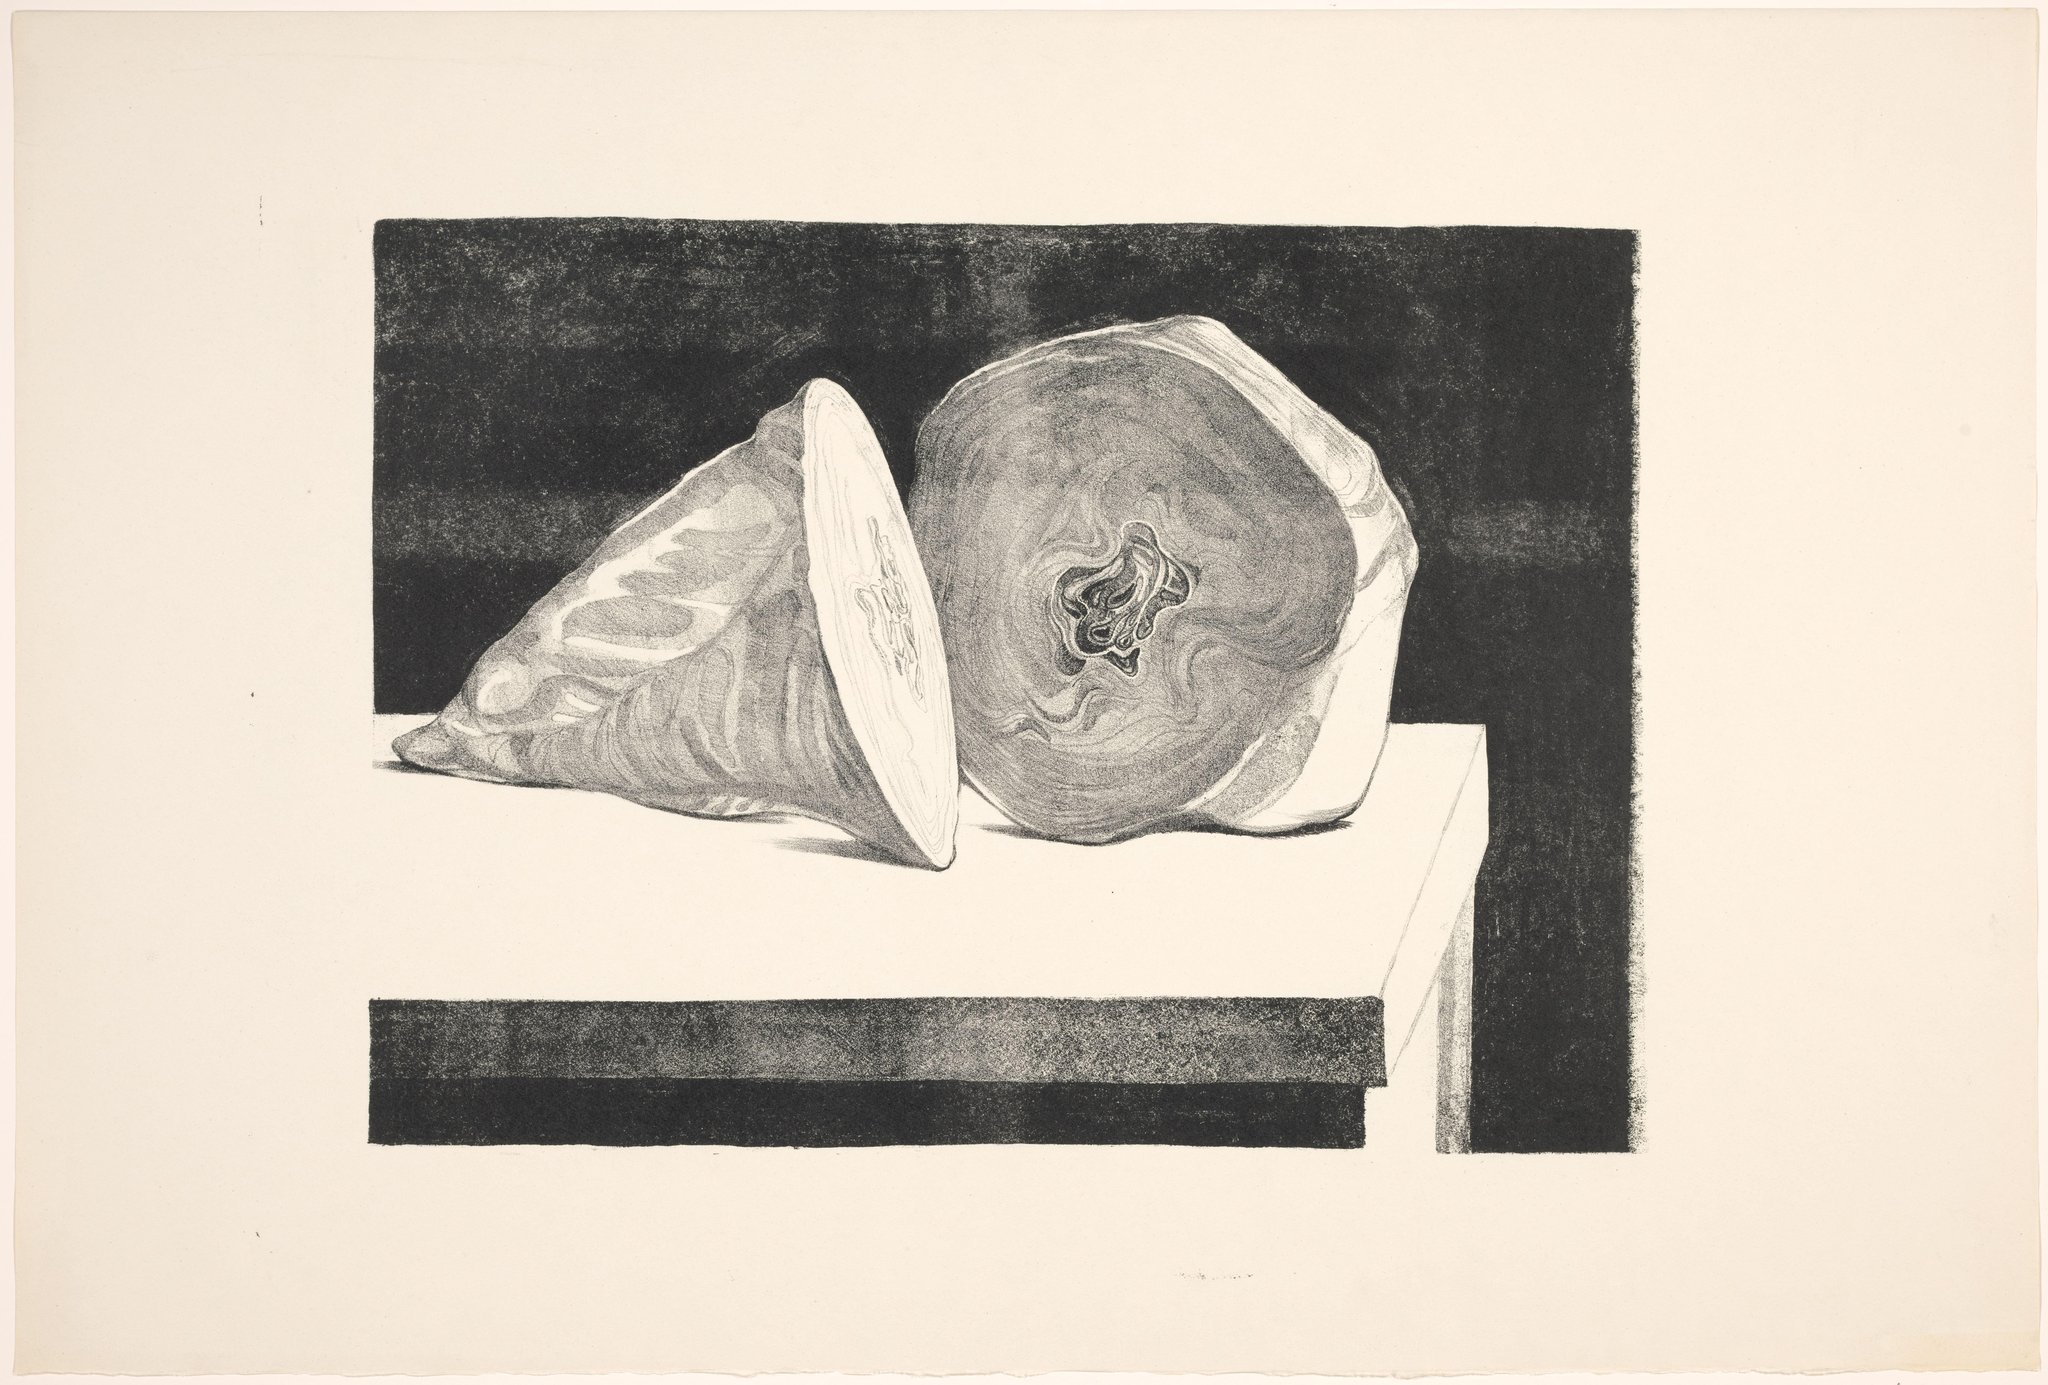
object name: print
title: Spitskool (grote versie)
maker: rein dool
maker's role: draughtsman, painter, print maker, sculptor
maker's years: 1933-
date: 1982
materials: paper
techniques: lithograph